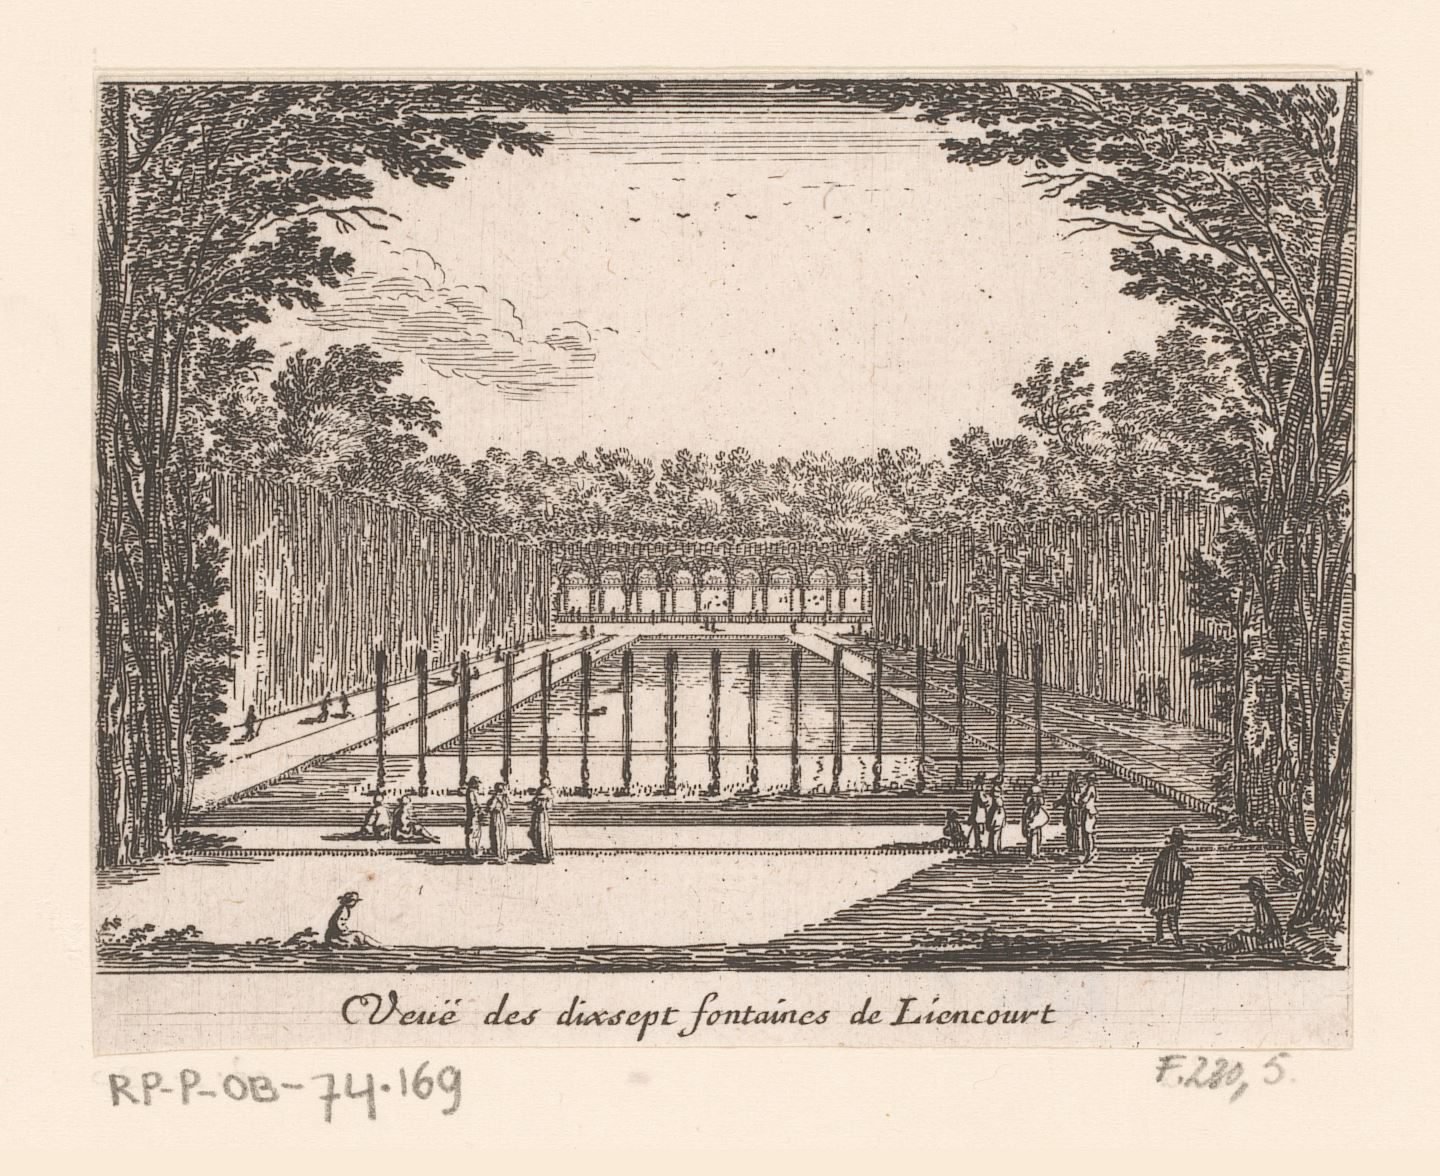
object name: print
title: Gezichten op het kasteel van Rochefoucauld in Liancourt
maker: israël silvestre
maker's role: draughtsman, print maker, publisher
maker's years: 1621-1691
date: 1631-1691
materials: paper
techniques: etching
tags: garden fountain, french or architectonic garden; formal garden, paris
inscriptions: collector's mark: Lugt 240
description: Prent maakt deel uit van een ongenummerde serie van negen prenten.